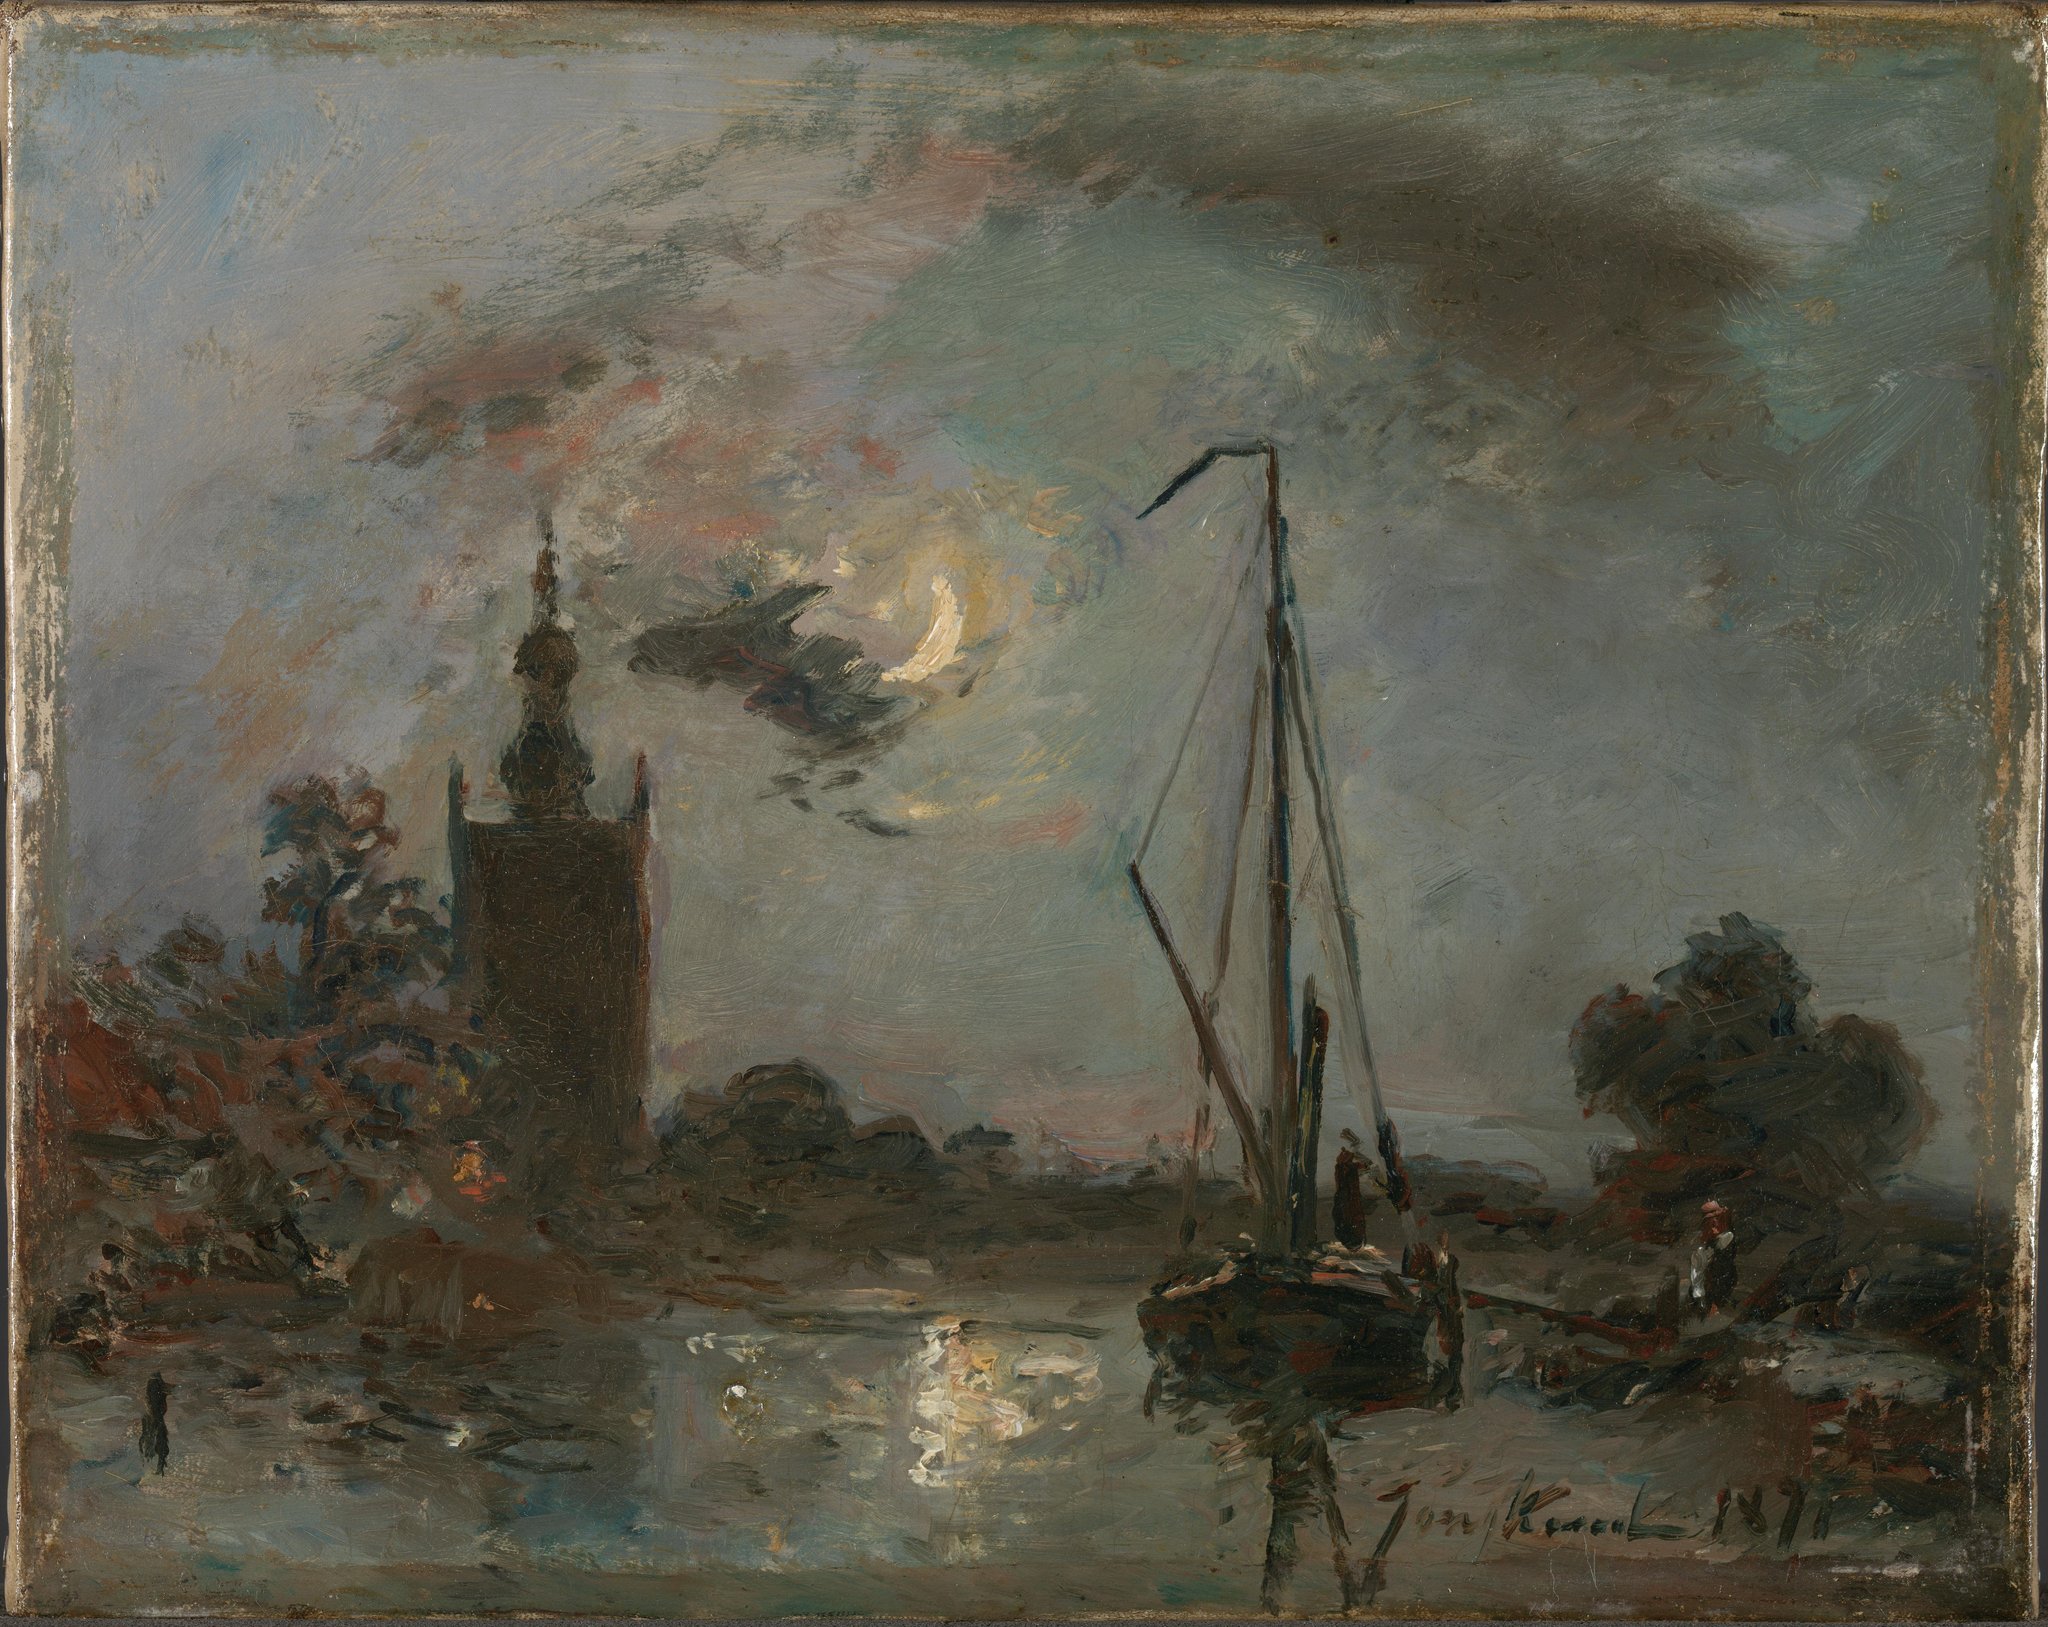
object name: painting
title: Overschie in the Moonlight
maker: johan barthold jongkind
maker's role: draughtsman, painter, print maker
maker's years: 1819-1891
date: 1871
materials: canvas, oil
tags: sailing-ship, sailing-boat, moonlight, parts of church exterior and annexes: tower, overschie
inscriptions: signature and date: ‘Jongkind 1871’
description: Rivierlandschap te Overschie bij maneschijn. Rechts een aangemeerde schuit met twee figuren, links een kerktoren.